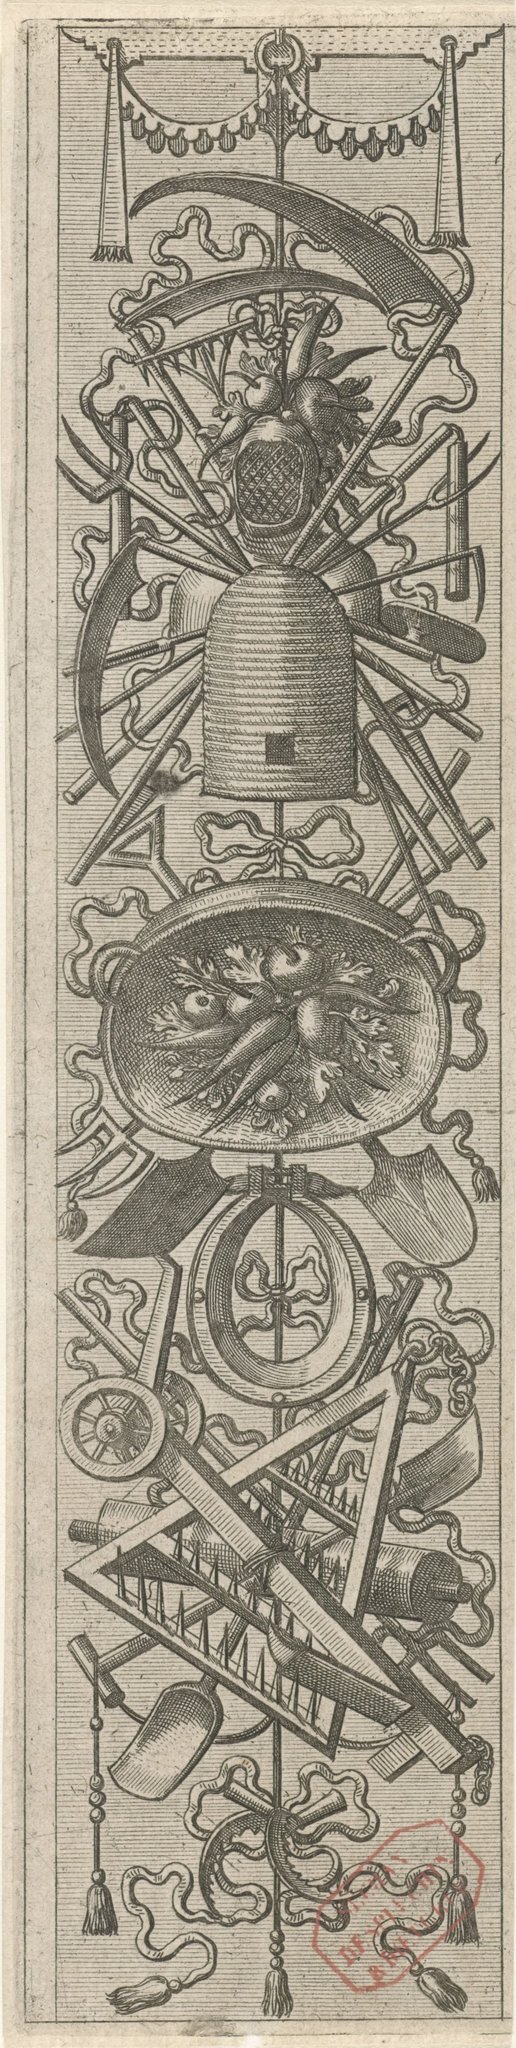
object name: print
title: Panoplia sev armamentarium…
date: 1572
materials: paper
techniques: etching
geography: netherlands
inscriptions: collector's mark: Lugt 2275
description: Landbouwwerktuigen en een bijenkorf. Uit serie, bestaande uit een titelblad en 16 bladen.